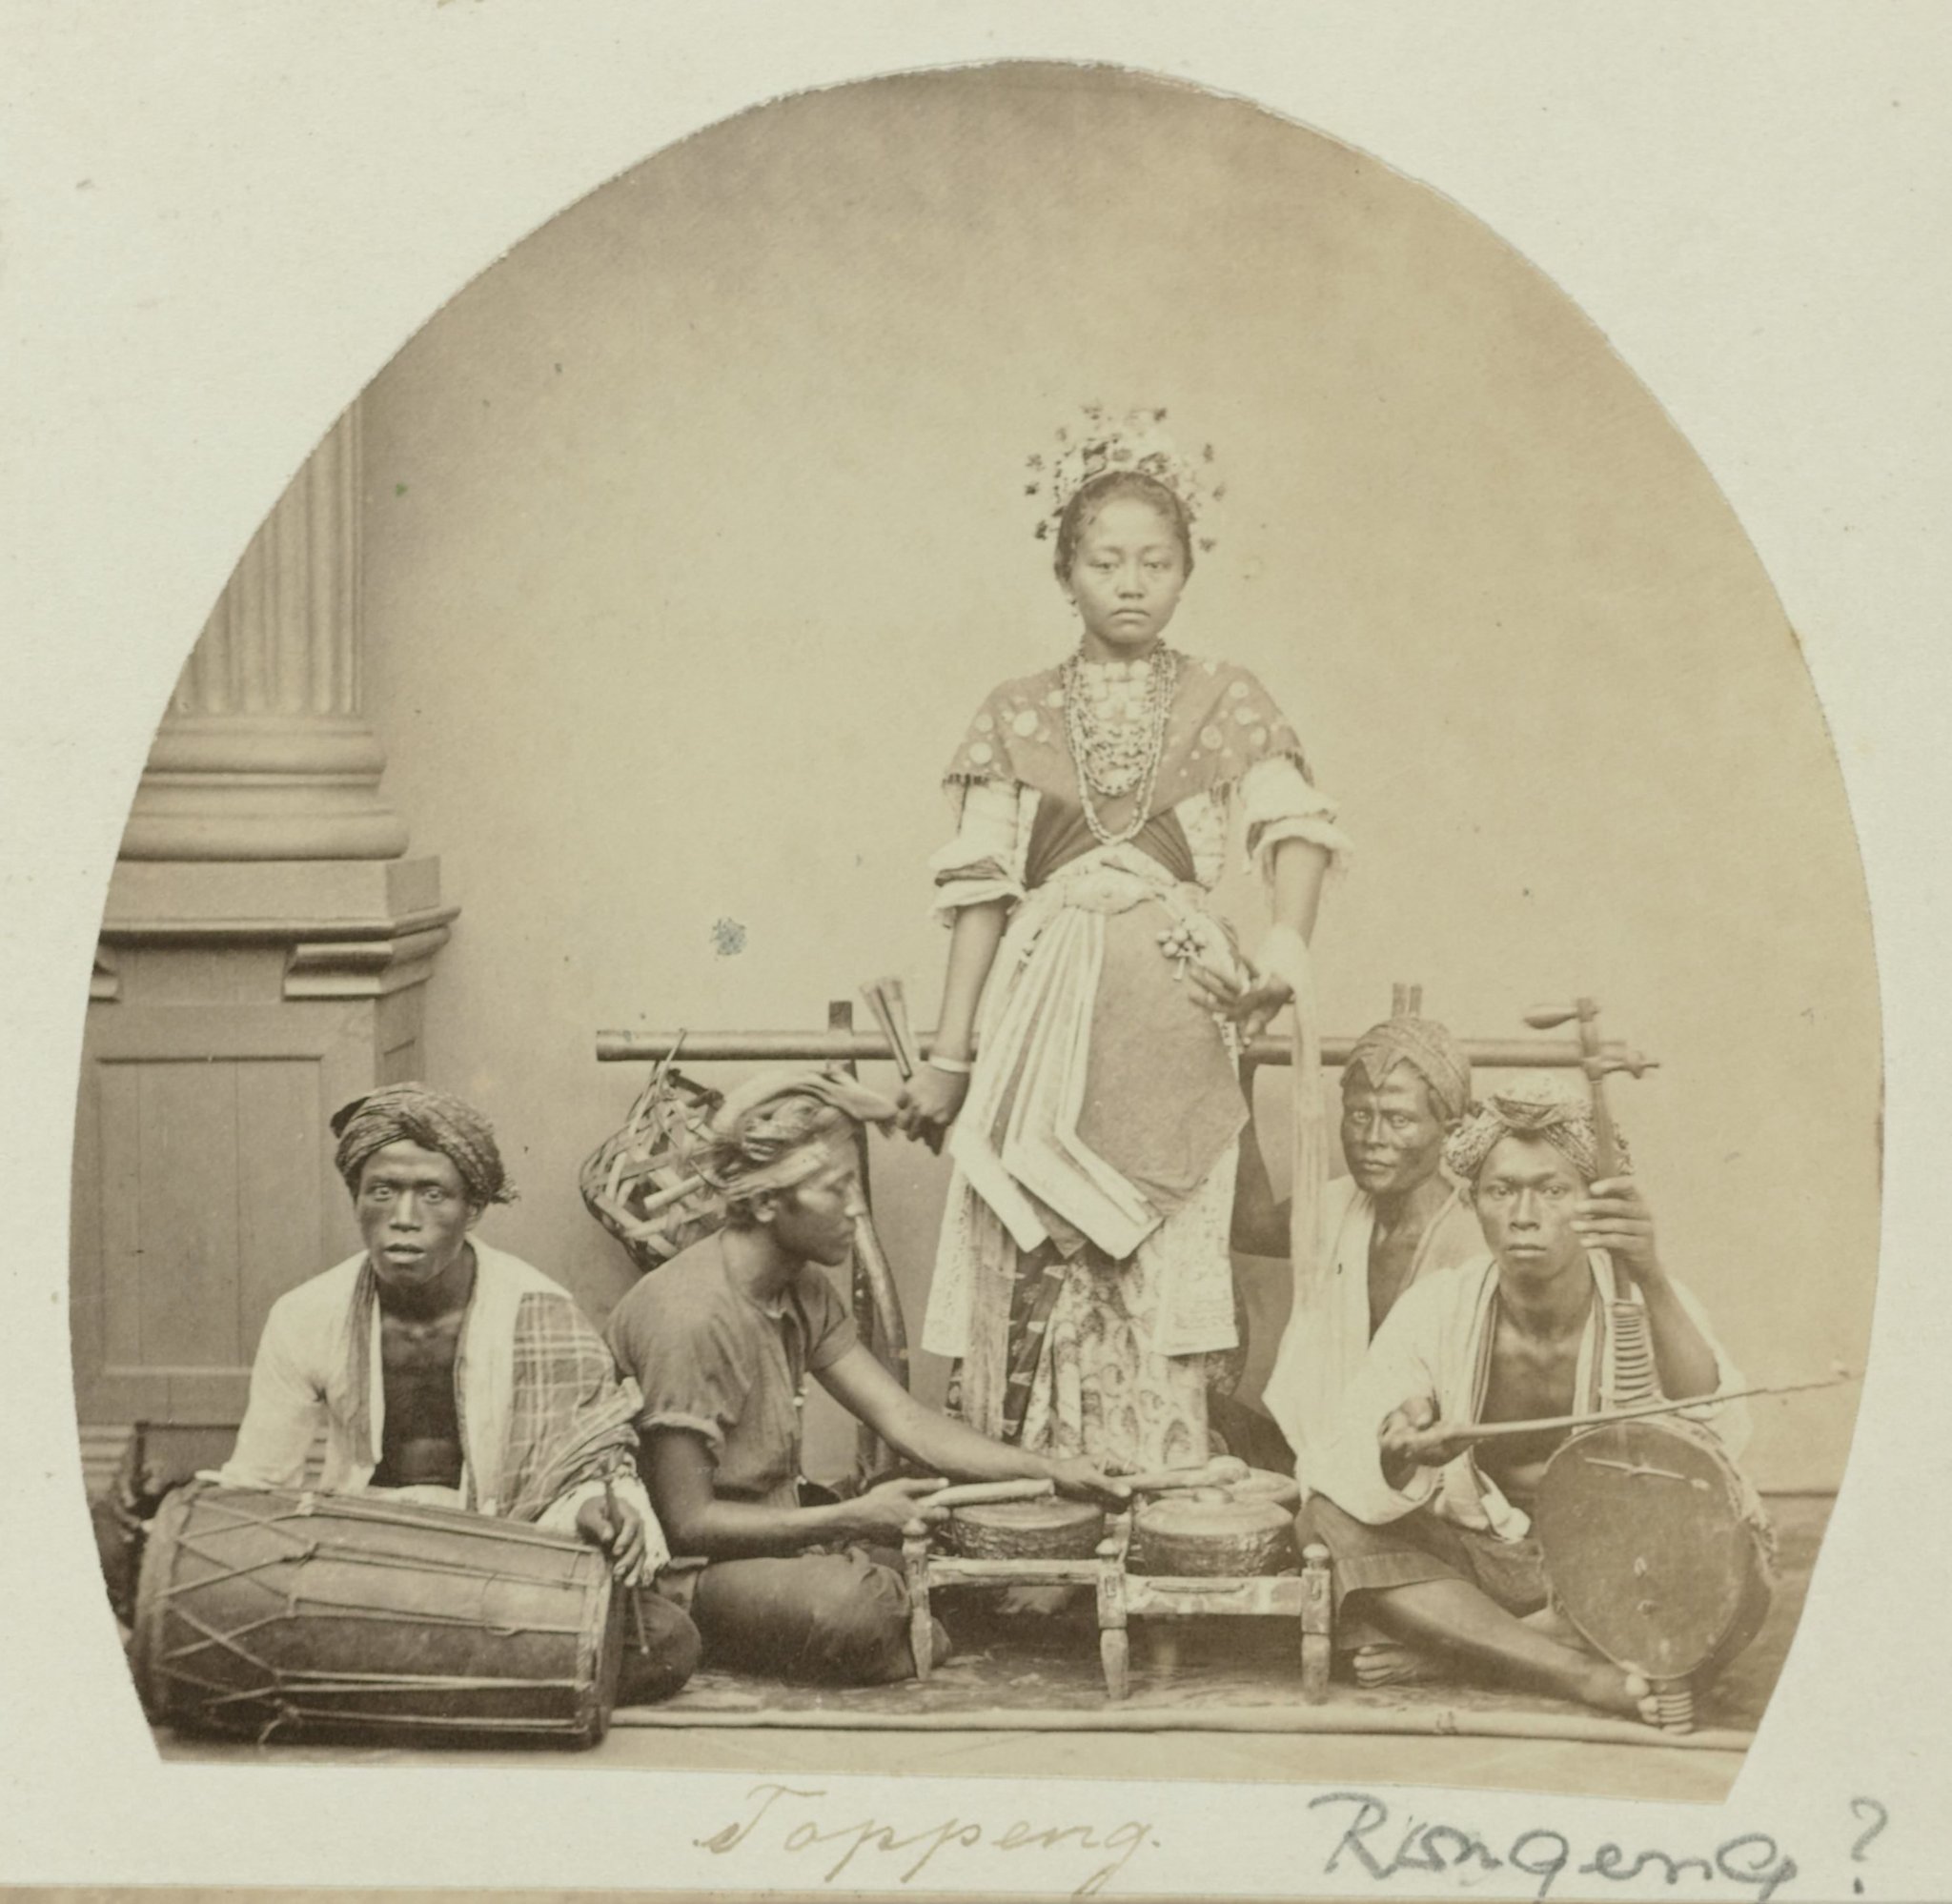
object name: photograph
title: Toppeng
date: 1863-1869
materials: photographic support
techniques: albumen print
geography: java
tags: small group of musicians, chamber orchestra, jazz band, woman dancing alone, java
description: Een Javaanse ronggeng danseres met vier muzikanten. Onderdeel van het groene fotoalbum met foto's van Java, uit het bezit van apotheker Specht-Grijp, die in 1865 vanuit Batavia naar Nederland terugkeerde.